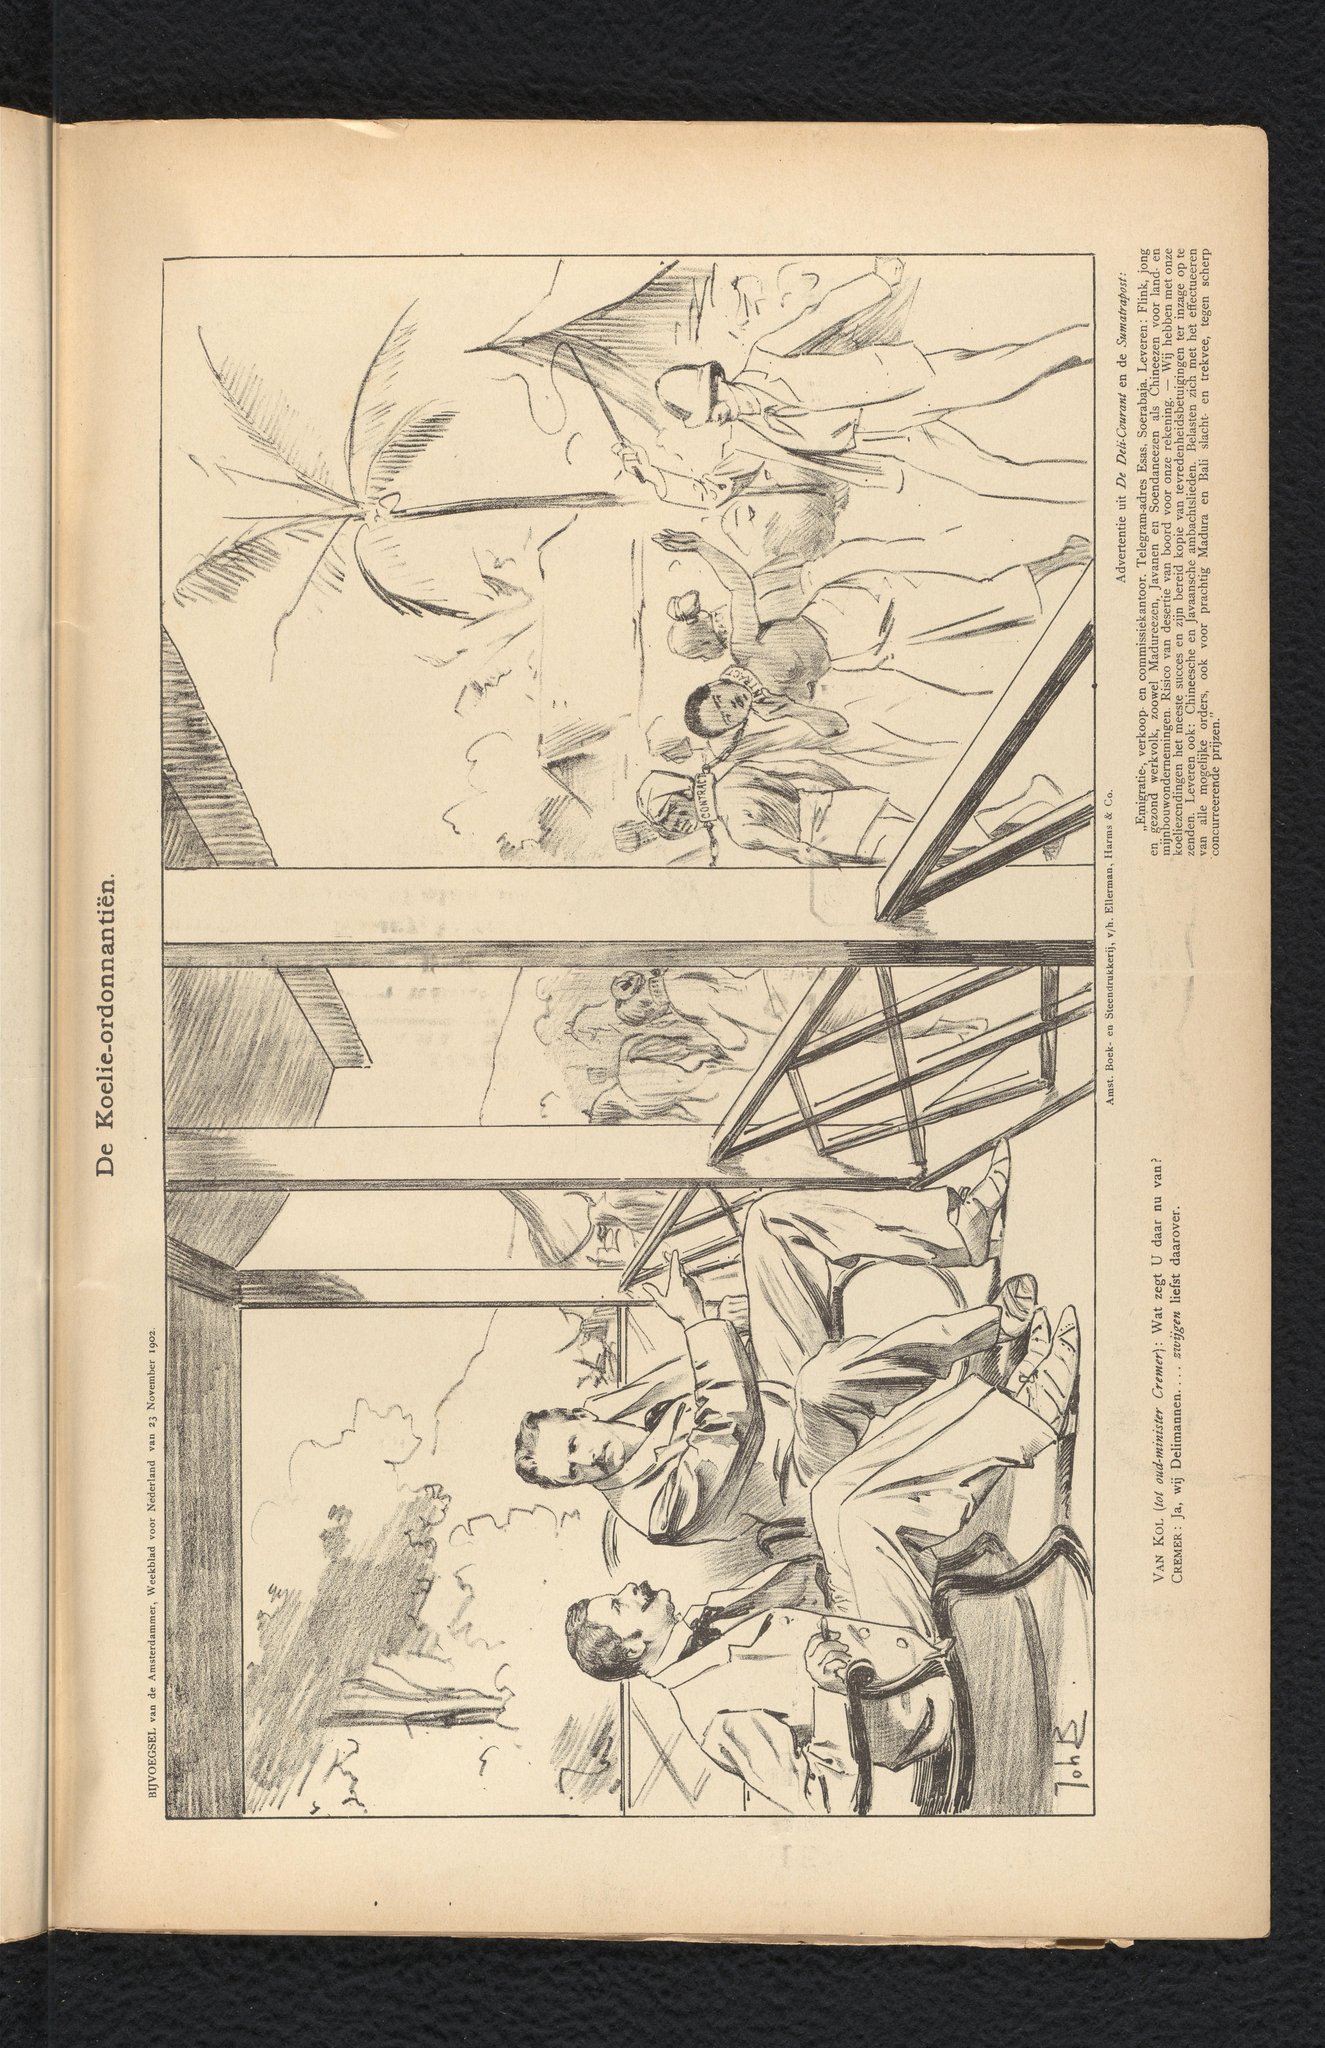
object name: cartoon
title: De Koelie-ordonnantiën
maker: johan braakensiek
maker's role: draughtsman, print maker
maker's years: 1858-1940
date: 1902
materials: paper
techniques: lithograph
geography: amsterdam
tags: amsterdam, engineer, hendrikus hubertus van kol, colonial system, slave-trade, working class, labourers, instruments of torture, execution or punishment: scourge, political caricatures and satires, dutch east indies, the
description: Kamerlid Henri van Kol wijst oud-minister van Koloniën Cremer op de behandeling van contractarbeiders als getekende tot slaafgemaakten in Nederlands-Indië. Een Nederlandse slavendrijver slaat met een zweep. Rechtsonder de afbeelding een overdruk van een advertentie uit de Deli-Courant over 'koeliezendingen'.